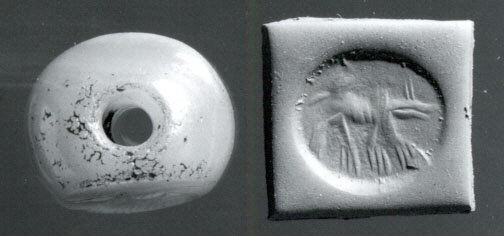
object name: stamp seal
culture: sasanian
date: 201-700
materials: stone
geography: iran or mesopotamia